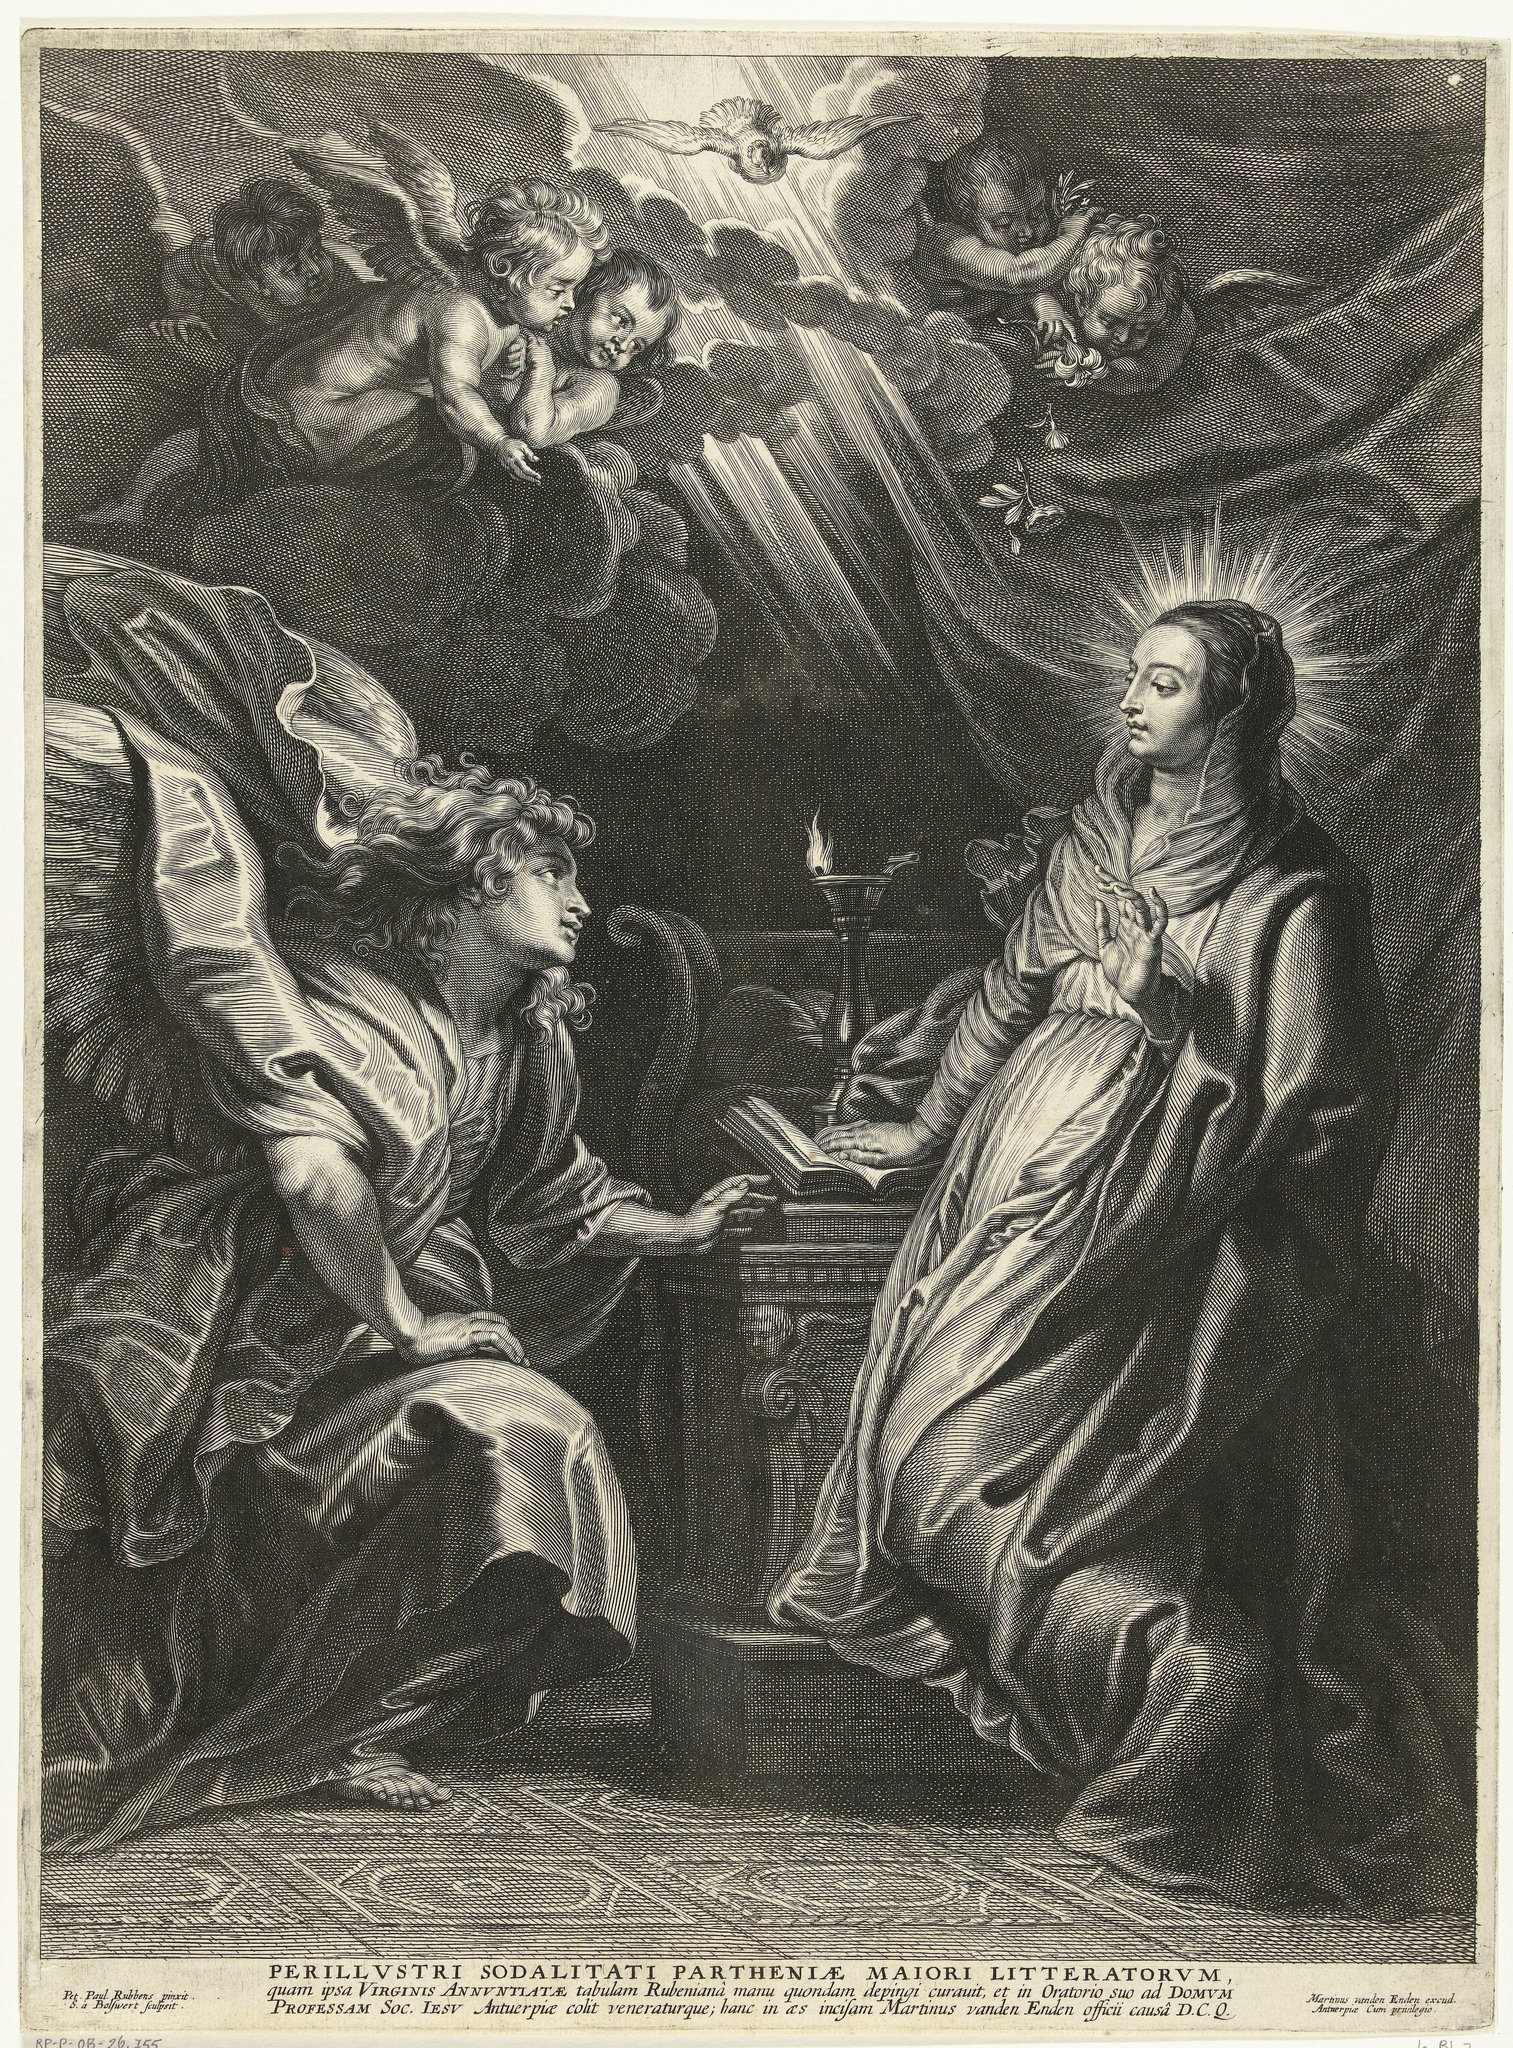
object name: print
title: Annunciatie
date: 1596-1659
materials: paper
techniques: engraving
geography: antwerp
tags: the annunciation: mary kneeling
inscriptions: inscription: ‘Perillvstri sodalitati Partheniae ... officii causâ D.C.Q’, collector's mark: Lugt 240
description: Prent naar schilderij van Peter Paul Rubens.